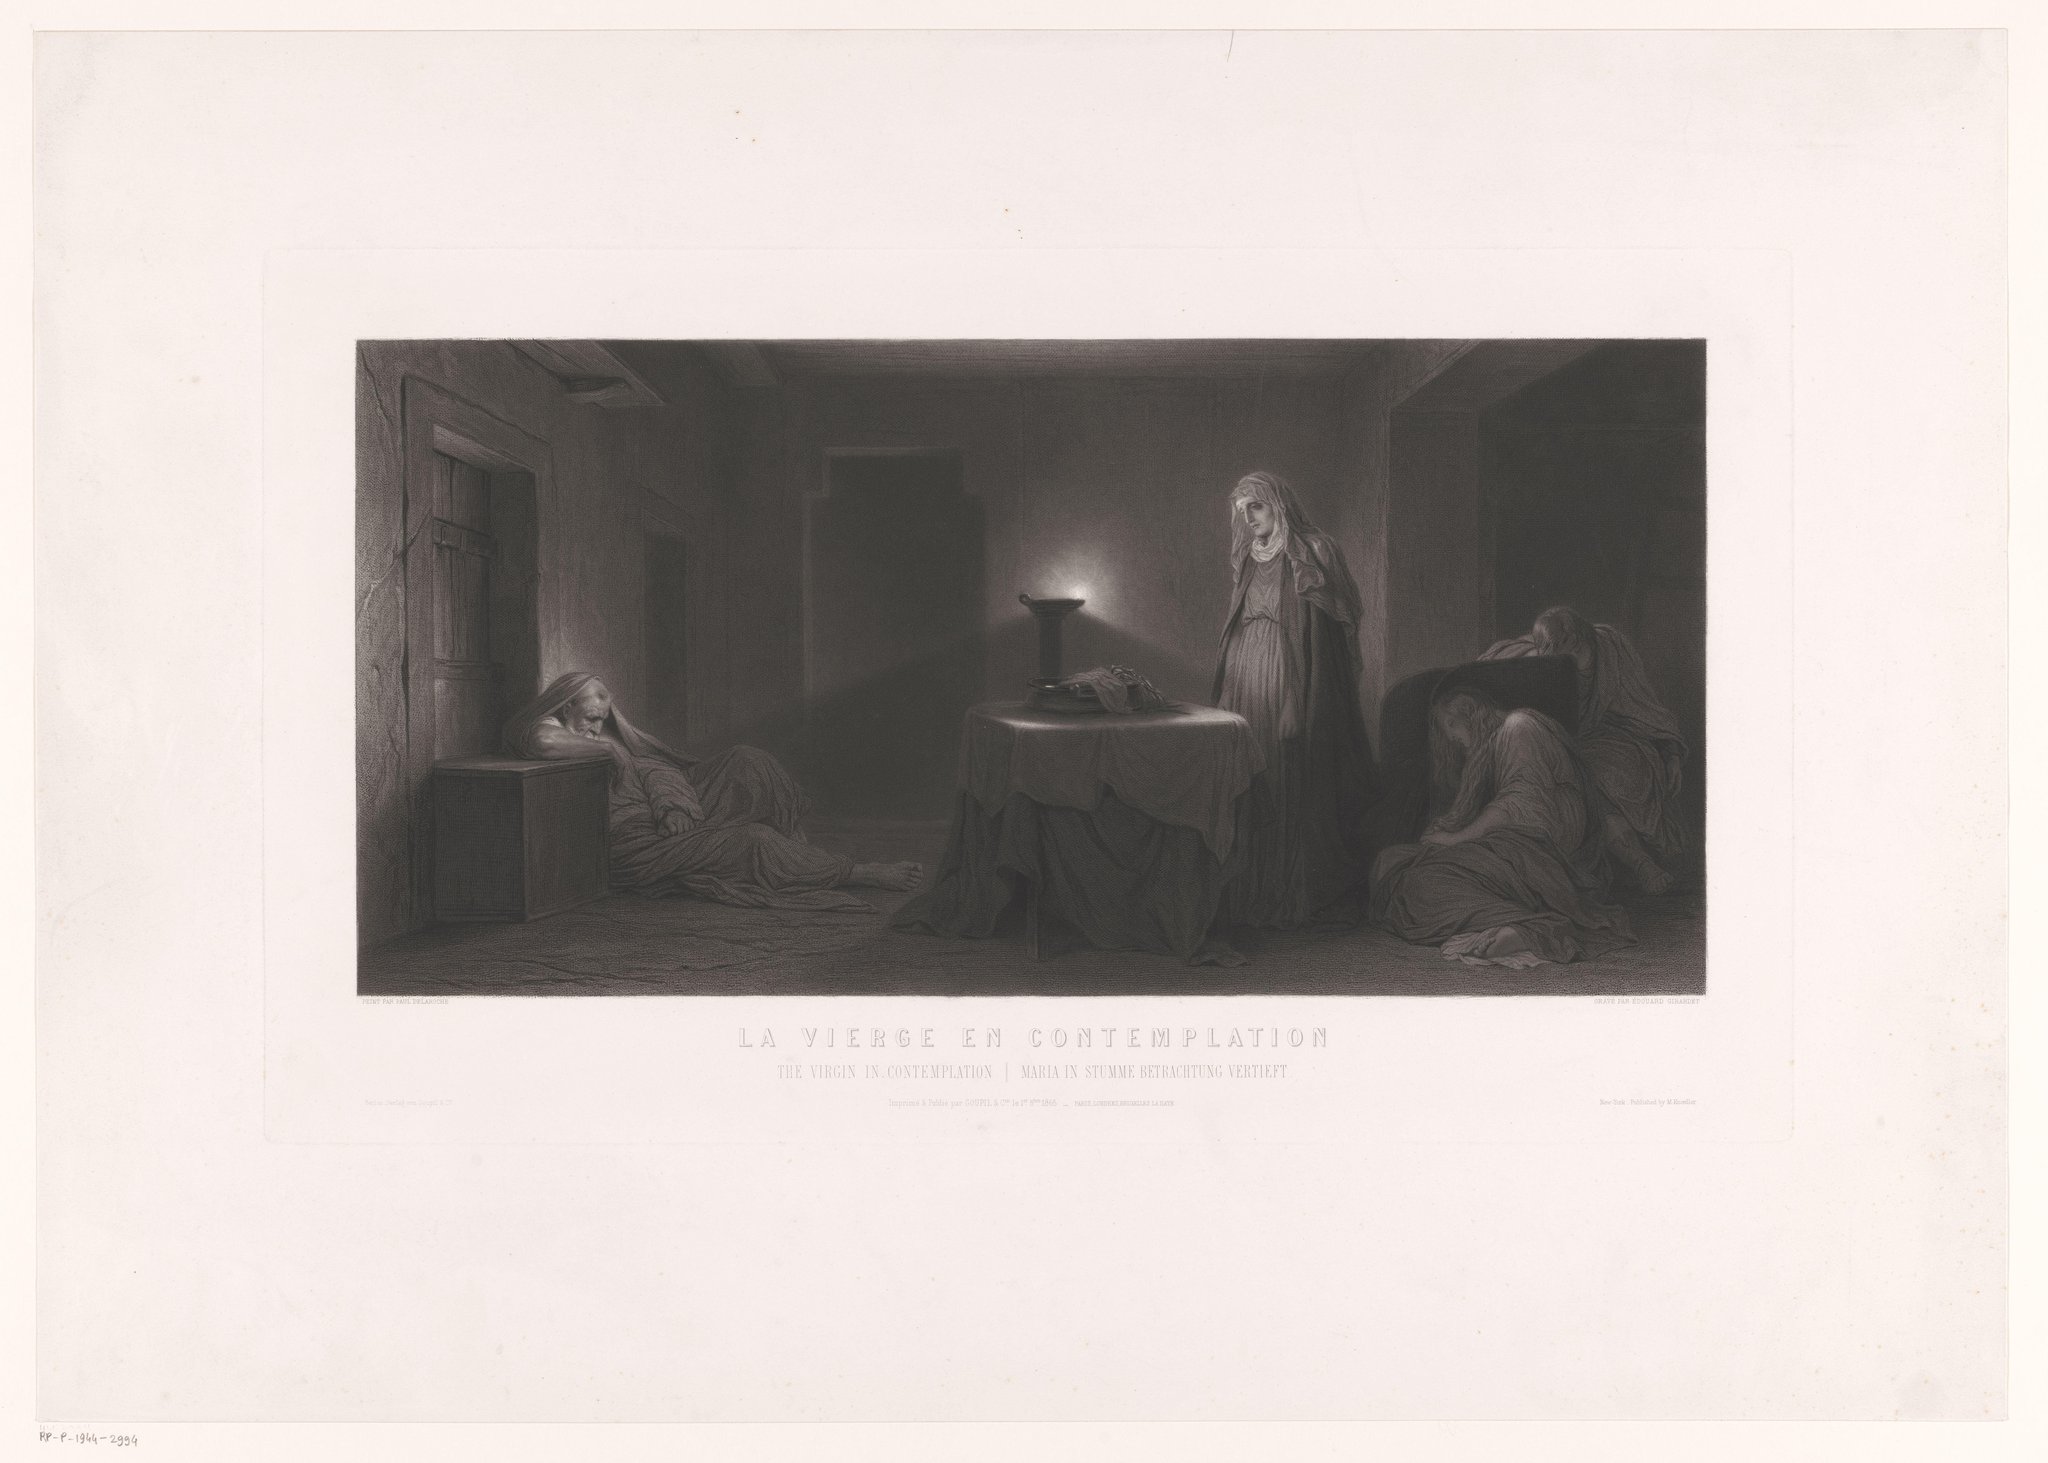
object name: print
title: La vierge en contemplation / The Virgin in Contemplation / Maria in Stumme Betrachtung Vertieft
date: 1865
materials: paper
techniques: engraving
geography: new york city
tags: the virgin mary, contemplation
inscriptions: collector's mark: Lugt 2228